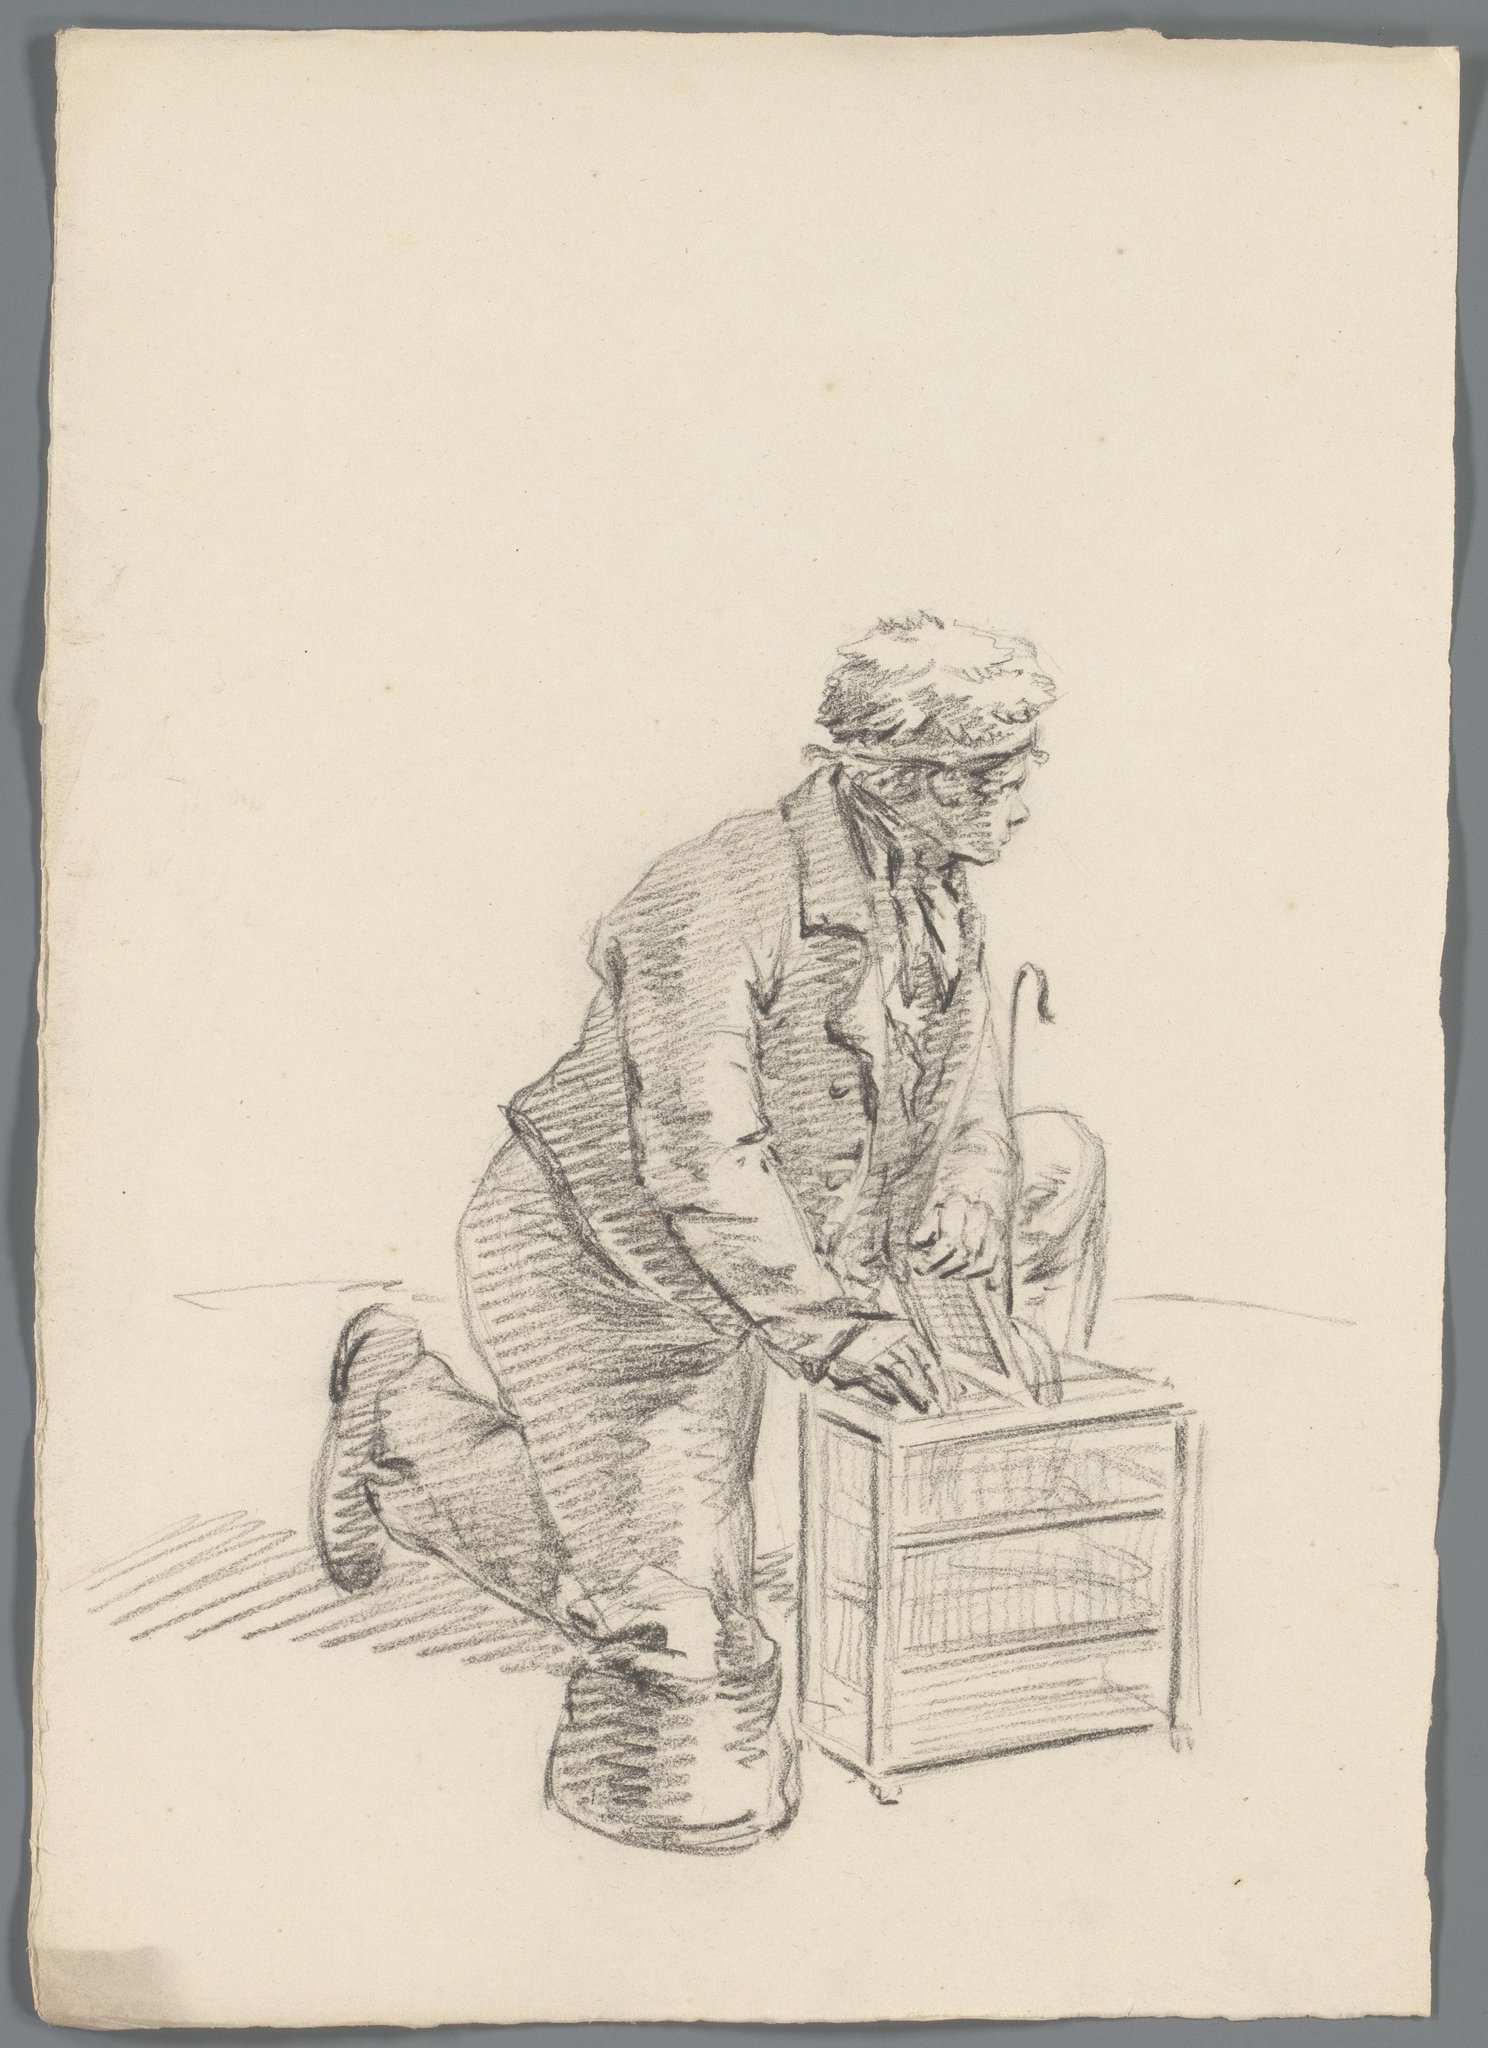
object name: drawing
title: Gehurkte man met een kooitje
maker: Anonymous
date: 1820-1830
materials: chalk, paper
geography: the hague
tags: empty bird cage, adult man, kneeling figure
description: Tekeningen waarschijnlijk ontstaan bij het Haagse kunstgenootschap ‘Tot Nut der Tekenkunst’, waar twee keer per week tekenavonden werden georganiseerd met geklede modellen.